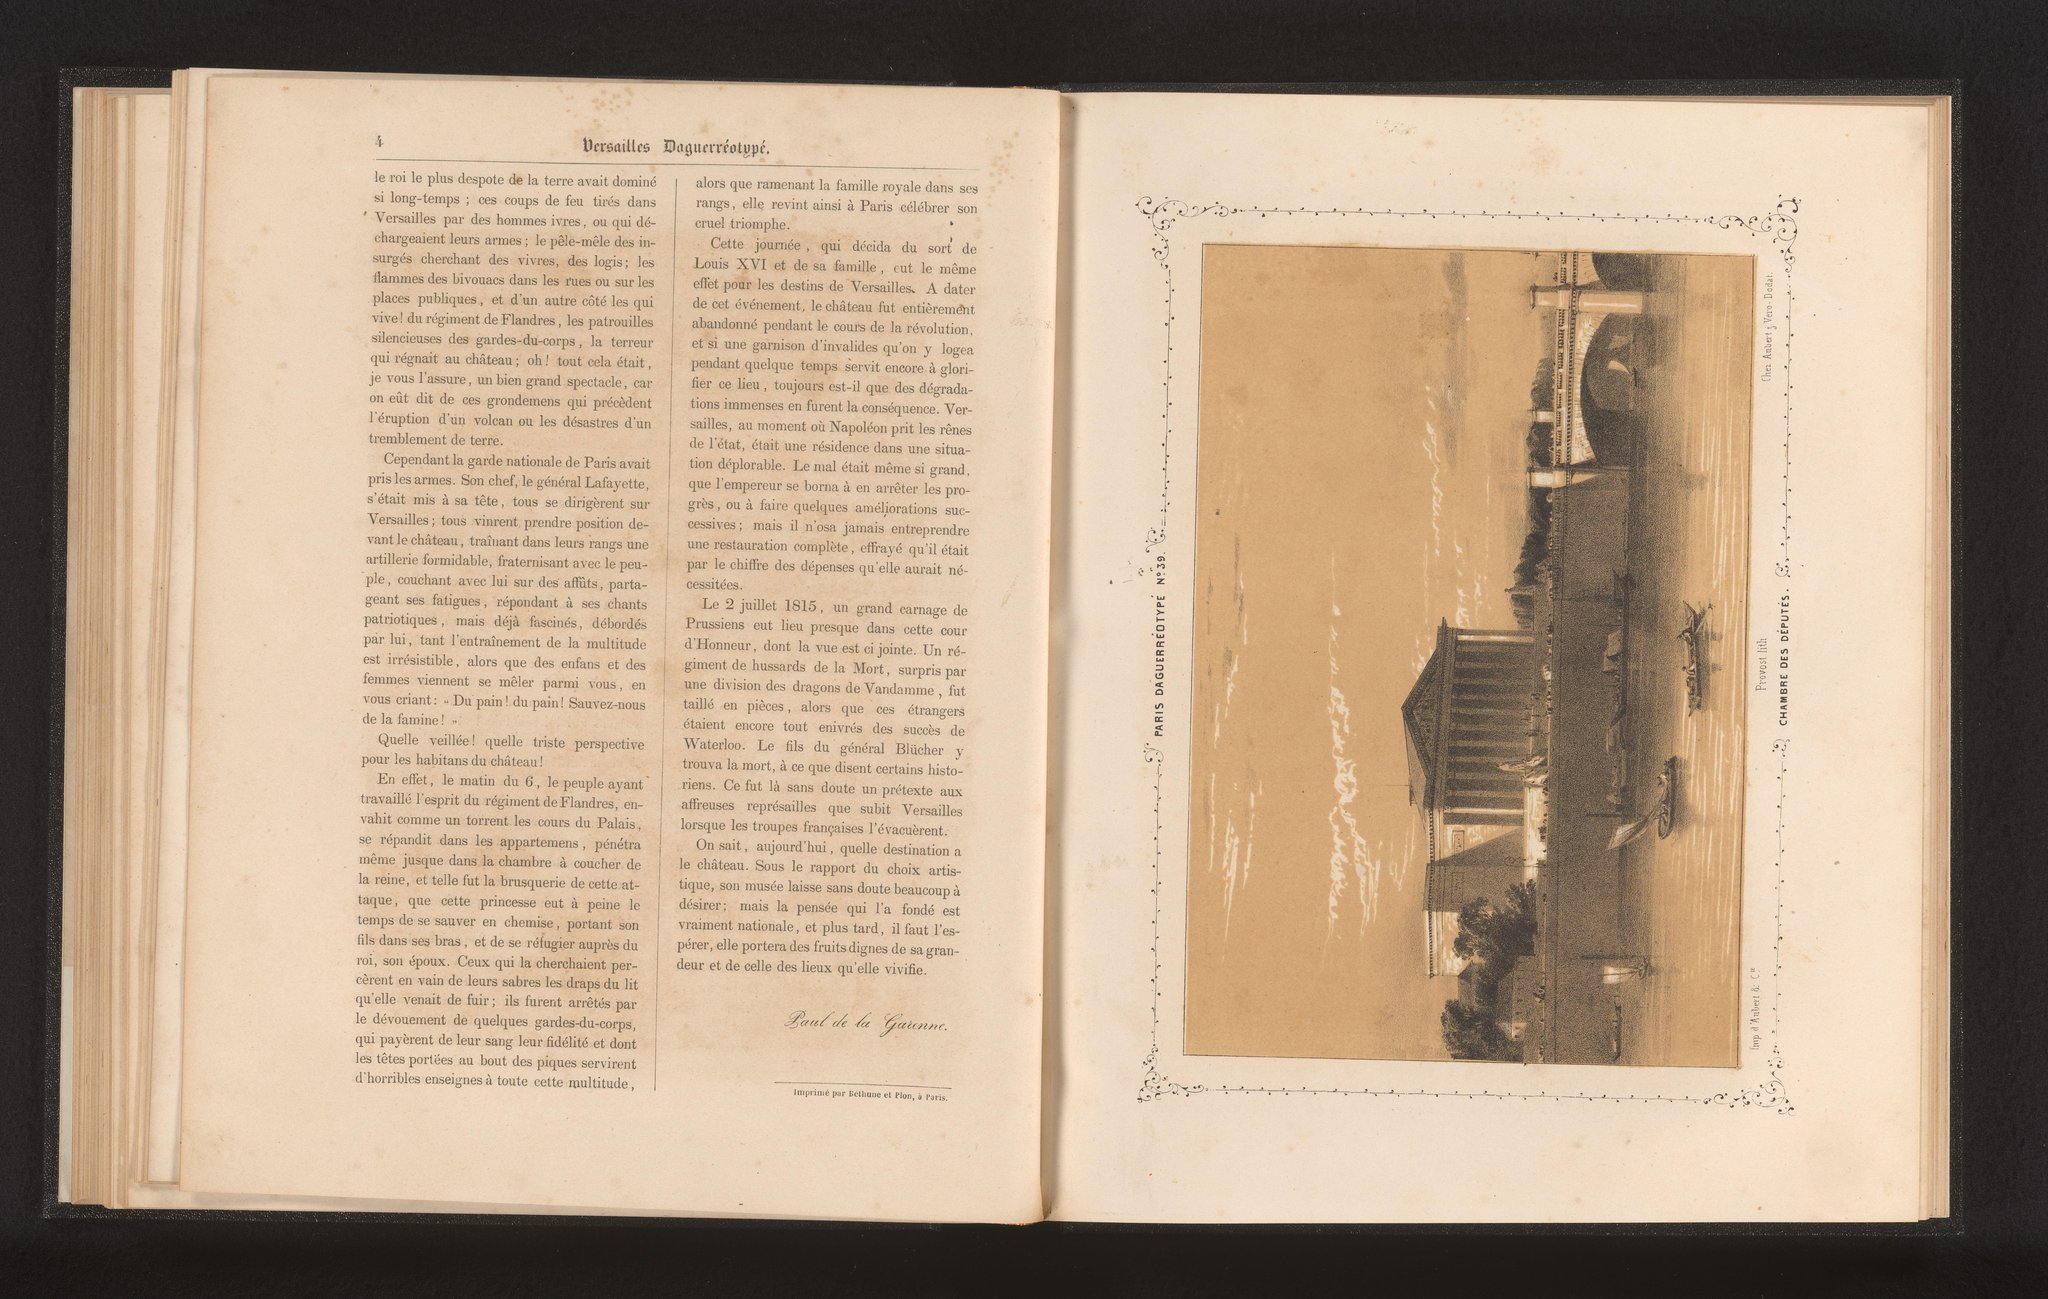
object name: print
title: Palais Bourbon in Parijs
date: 1839-1840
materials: paper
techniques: tone lithography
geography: paris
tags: palace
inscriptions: inscription: ‘PARIS DAGUERRÉOTYPÉ No. 39.’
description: Prent op honderdvijfenvijftigste ongenummerde pagina.